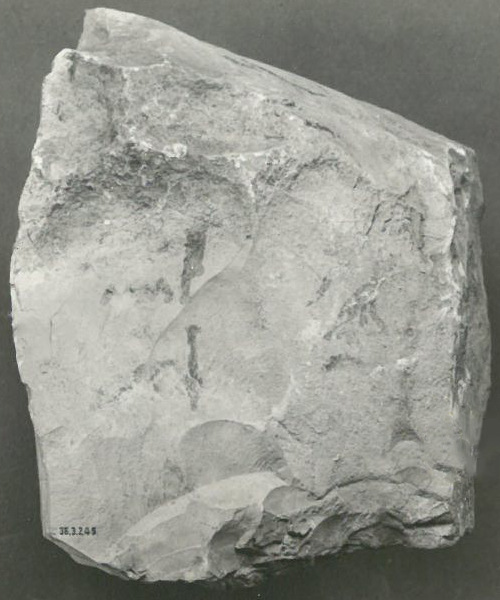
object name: name stone, tally, senenmut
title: Name Stone of Senenmut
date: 1479-1458 BCE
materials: limestone, paint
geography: egypt